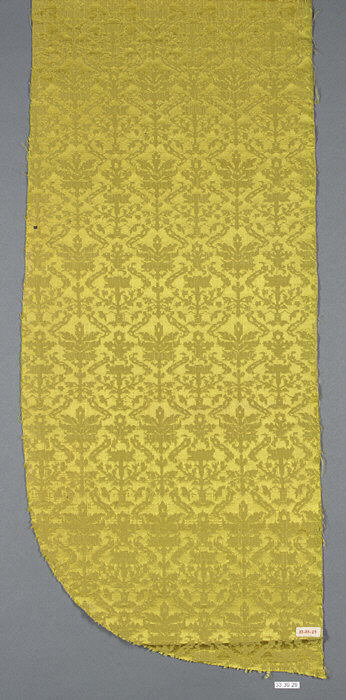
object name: piece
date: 1501-1700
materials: silk